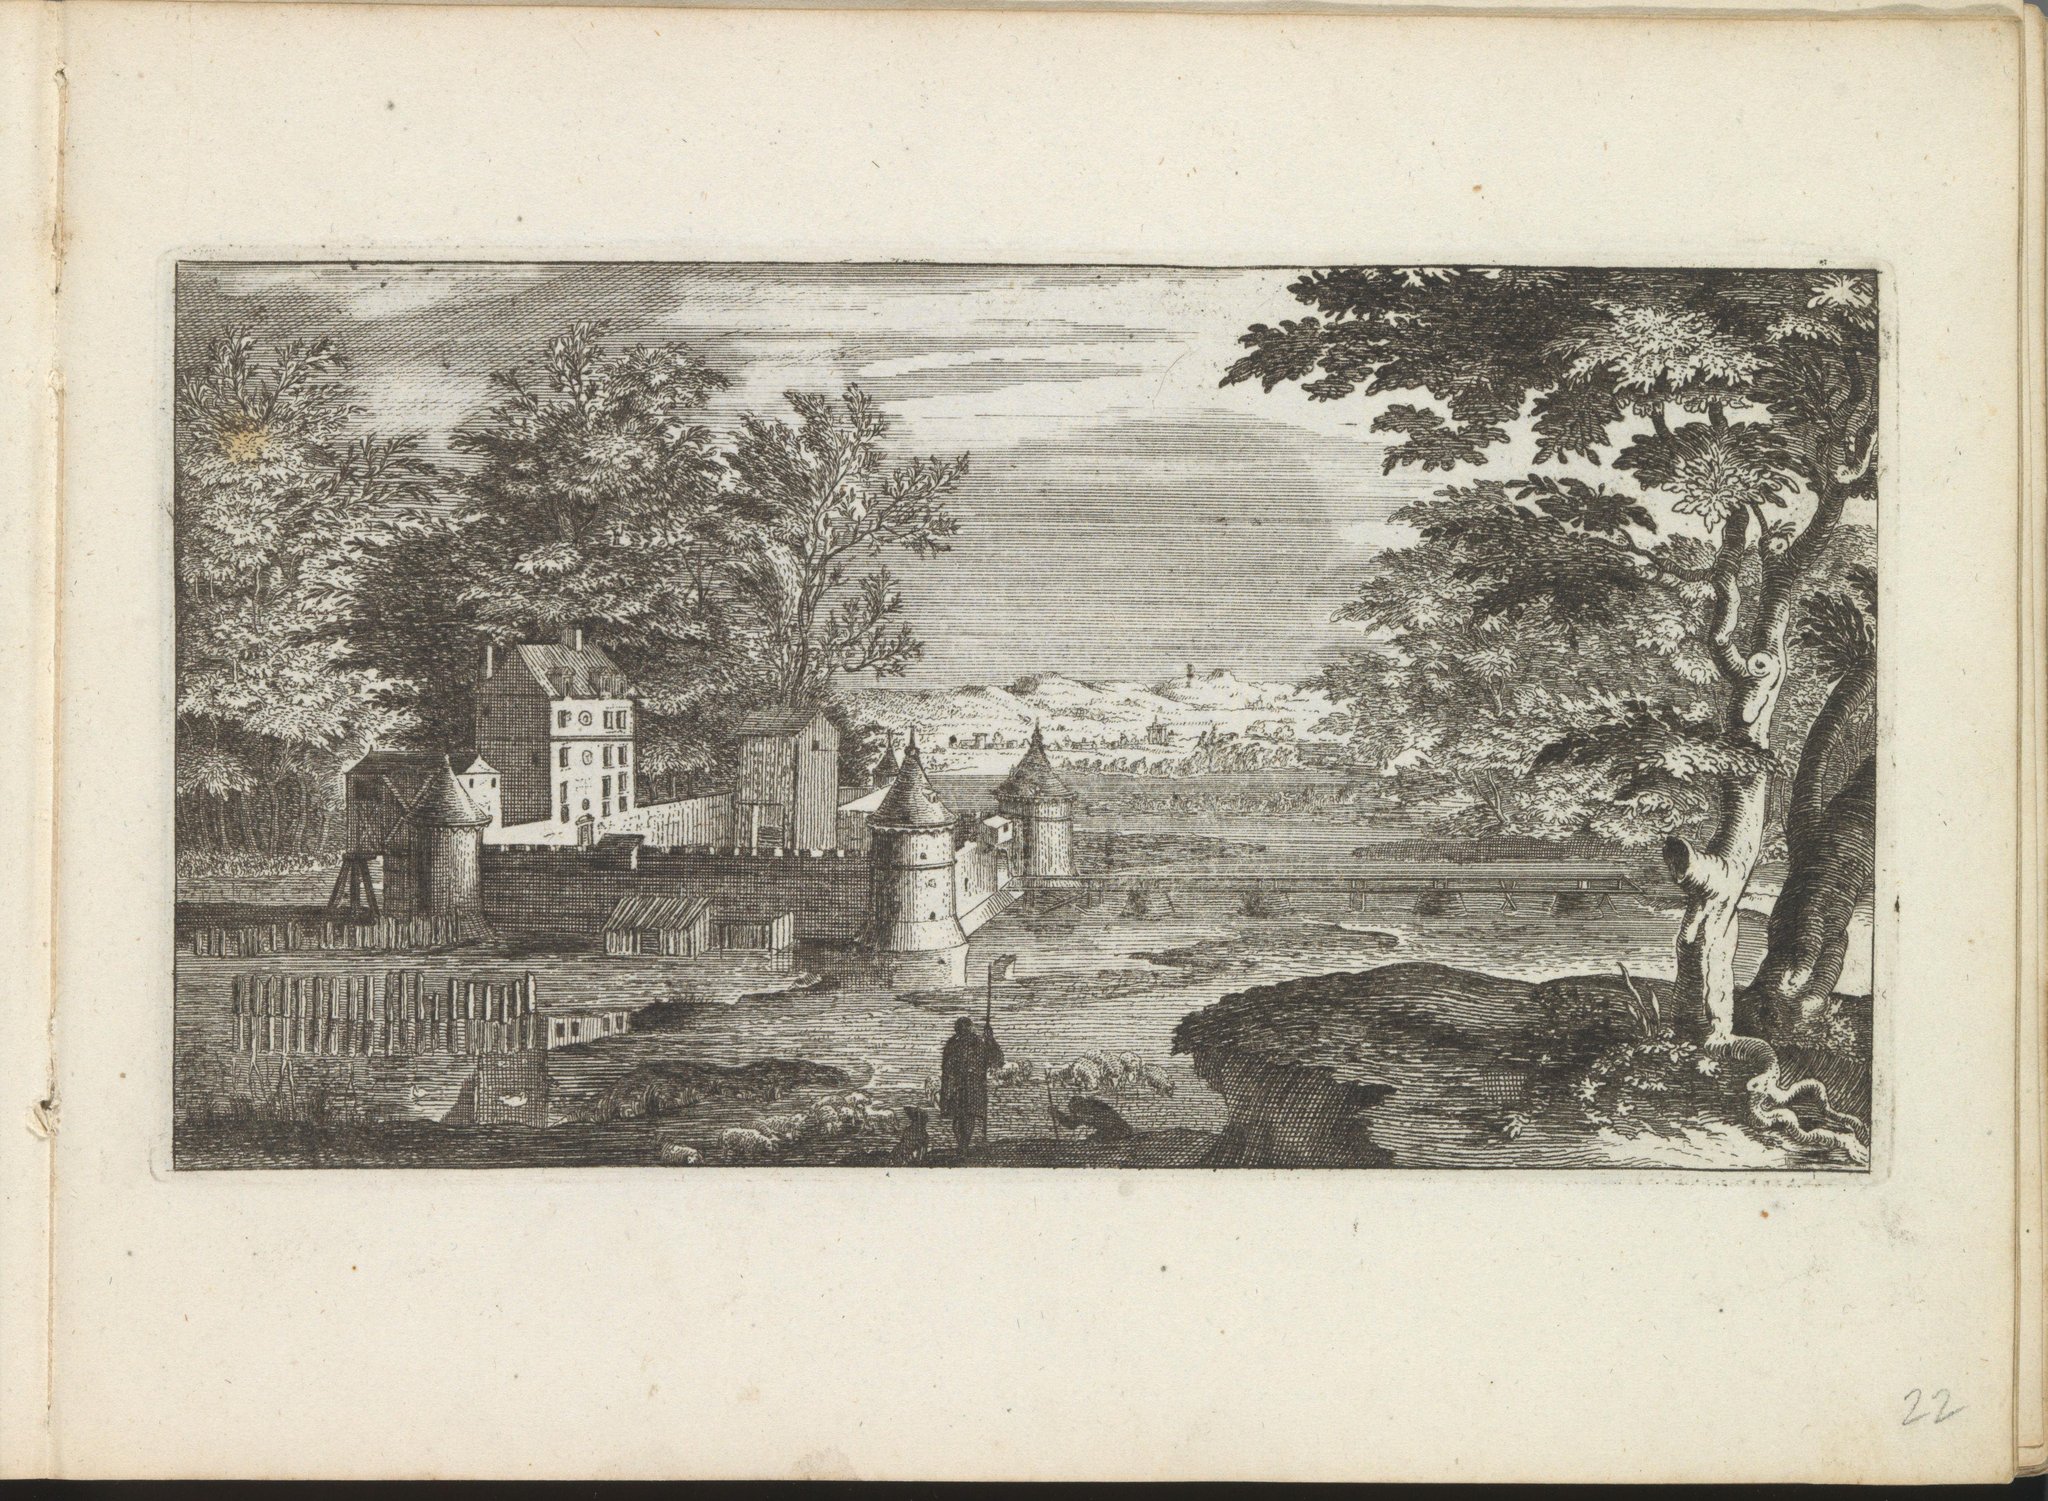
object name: album leaf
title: Spiegel der natuur en school der teekenkunde (...)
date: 1600-1699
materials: paper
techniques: etching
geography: amsterdam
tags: landscapes in the temperate zone, landscape with tower or castle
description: Landschap met een kasteel aan het water. De prent maakt deel uit van een album.